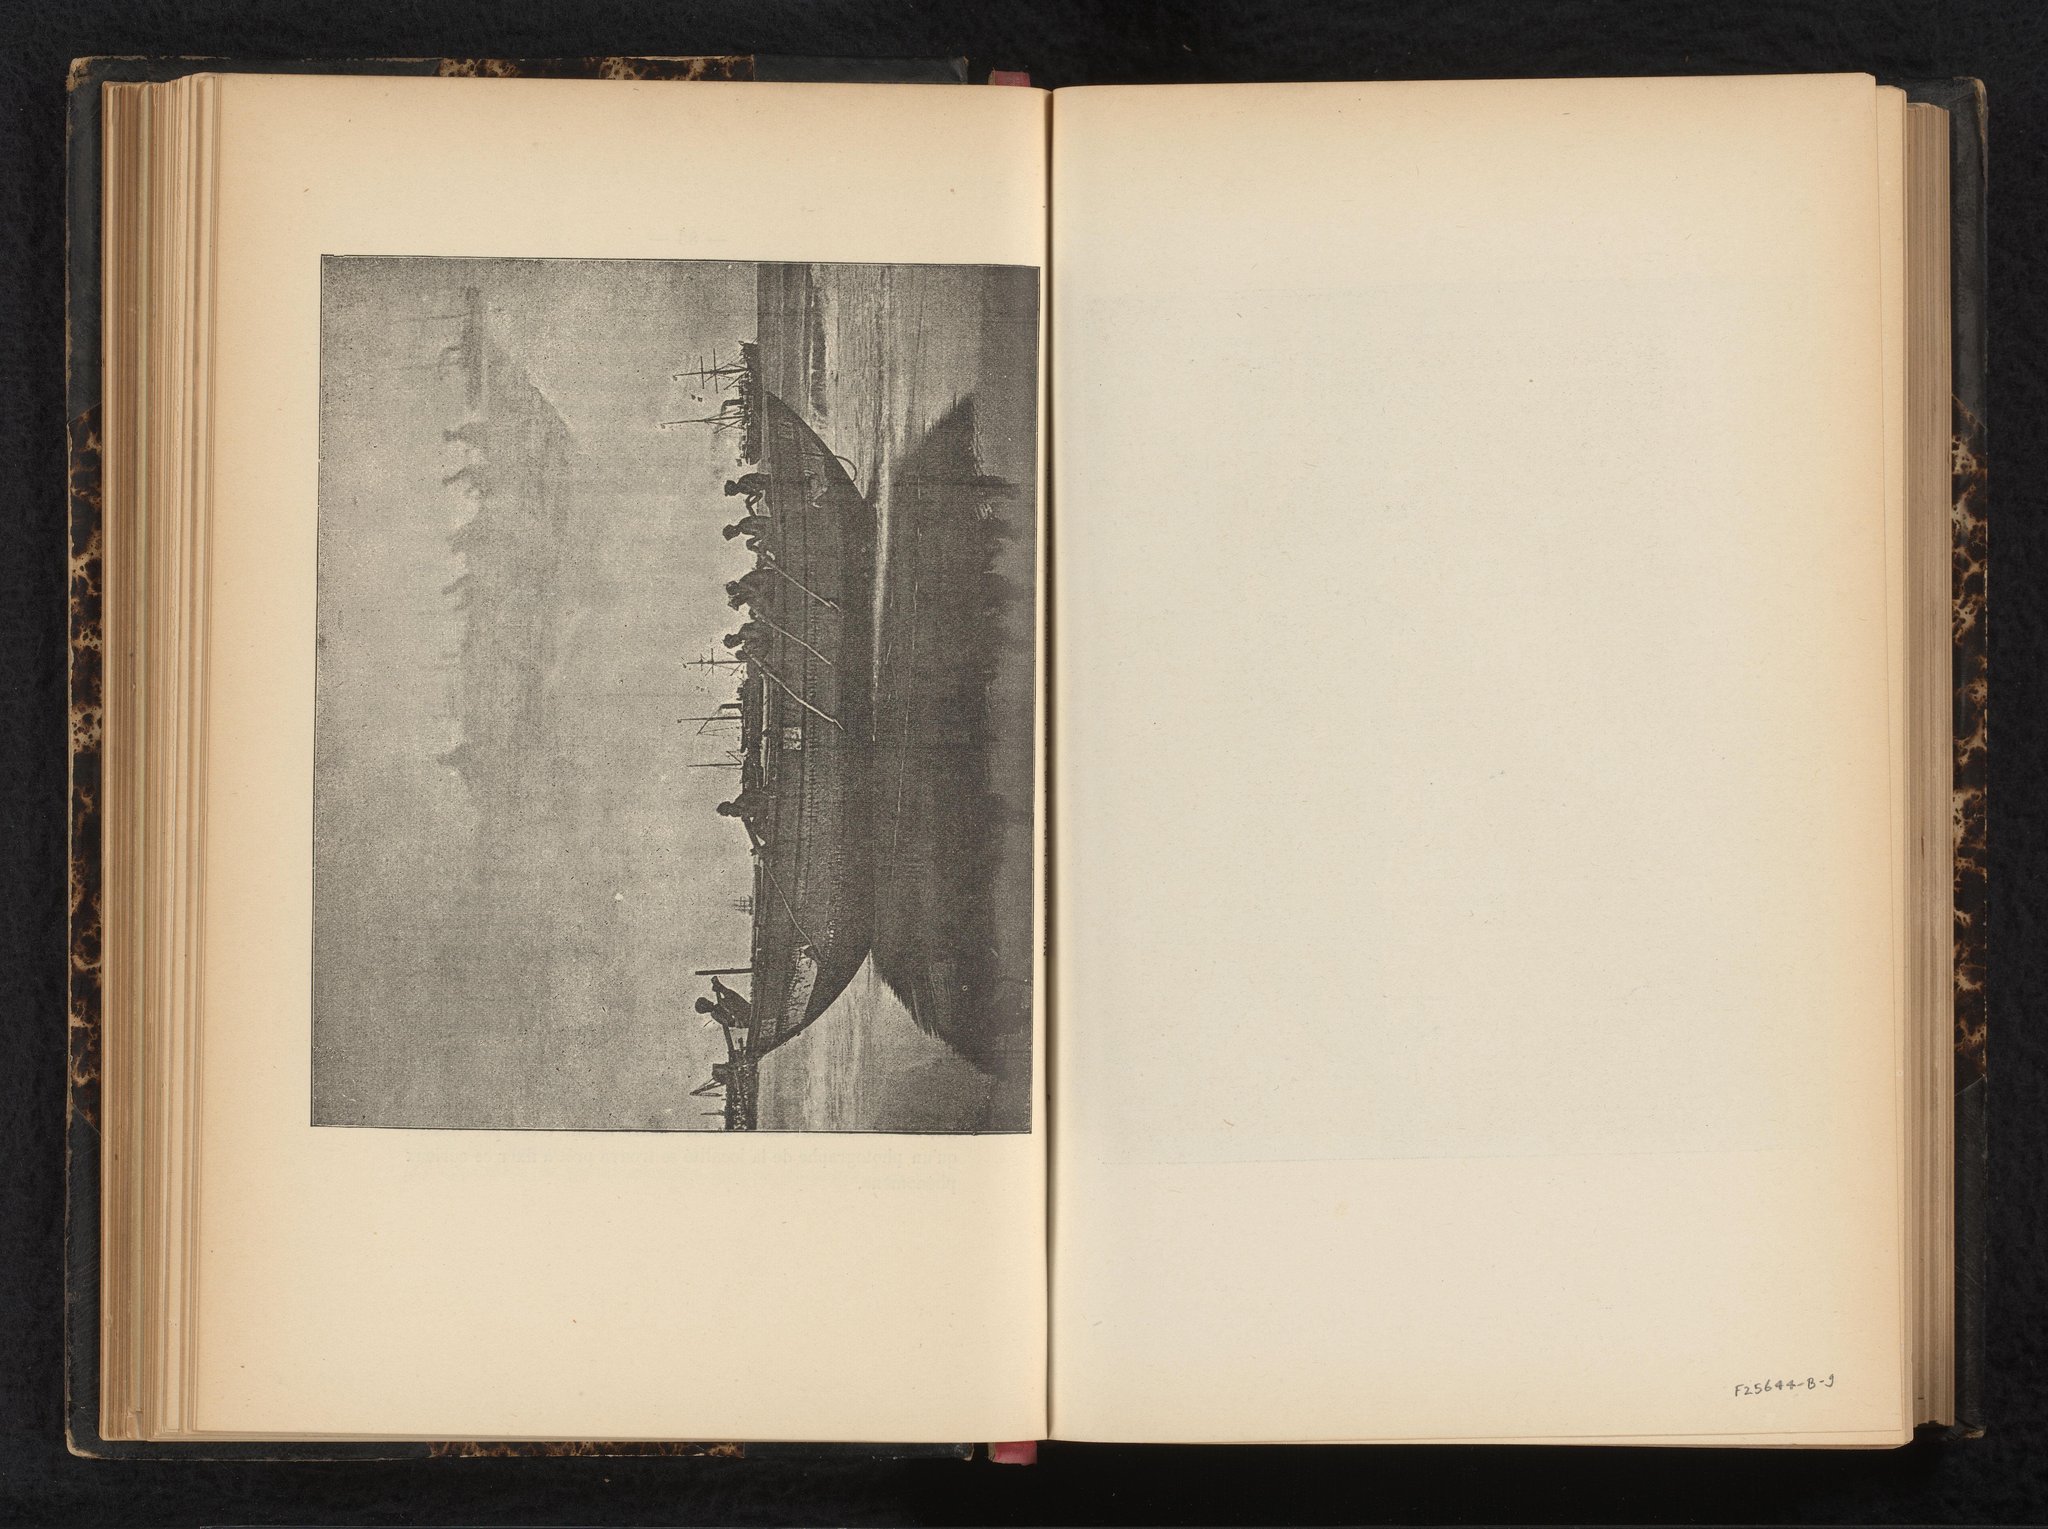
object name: photomechanical print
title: Mirage observé le 17 juin 1886, à Madras, et reproduit d'après une photographie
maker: Anonymous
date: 1886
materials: paper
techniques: autotype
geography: chennai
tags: mirage, 'fata morgana', rowing facing backward, pulling